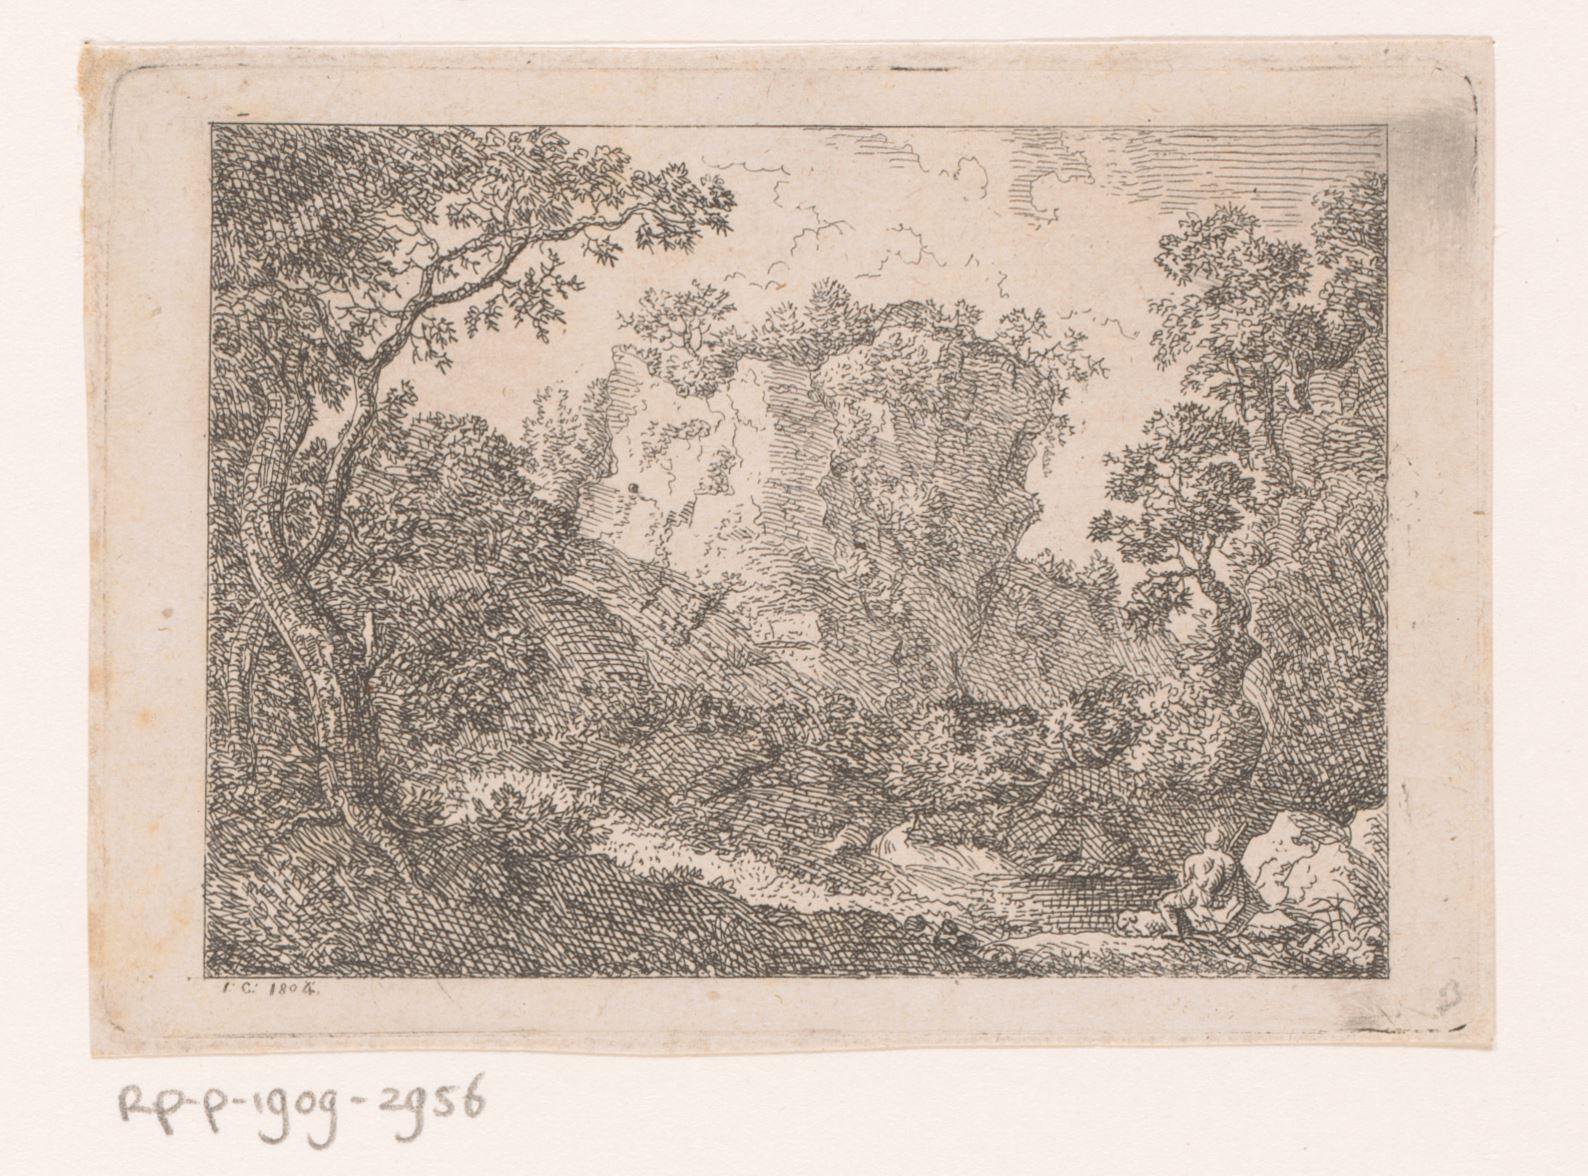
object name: print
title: Landschap met hoge rots en een herder op de voorgrond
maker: joseph charles cogels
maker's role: print maker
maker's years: 1785-1831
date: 1804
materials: paper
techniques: etching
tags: landscapes, herding, herdsman, herdswoman, shepherd, shepherdess, cowherd, etc., rock-formations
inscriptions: collector's mark: Lugt 2228, collector's mark: Lugt 1485, inscription: ‘Rochers pres de la grotte aux environs de Düsseldorff’